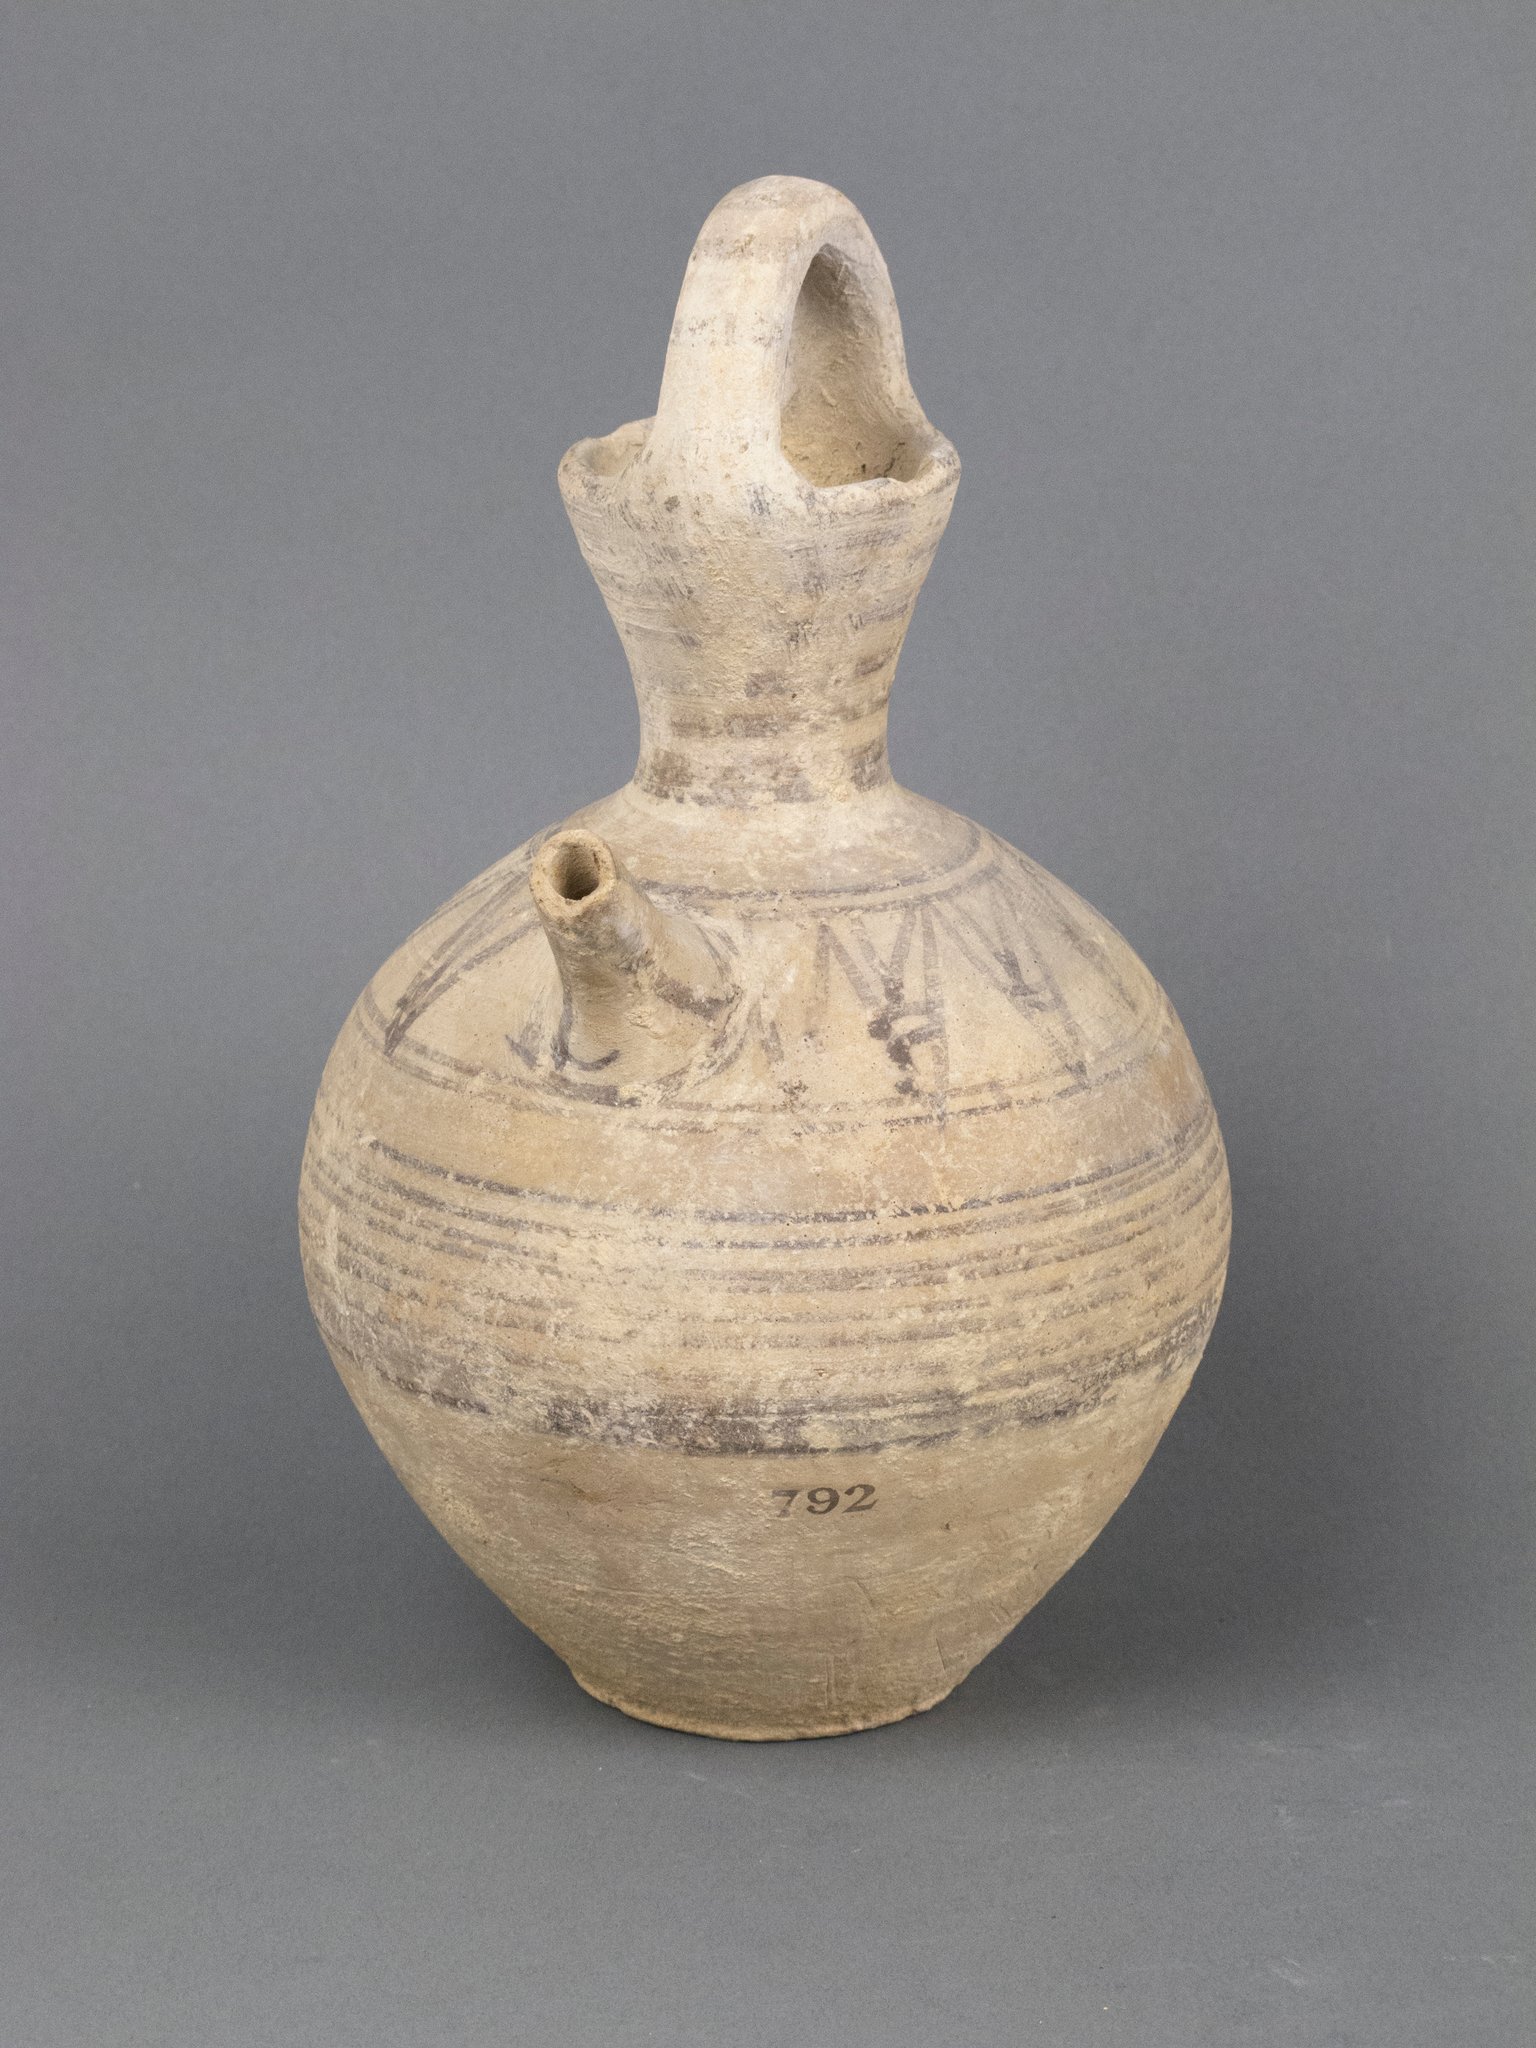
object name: juglet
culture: cypriot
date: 750-600 BCE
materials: terracotta